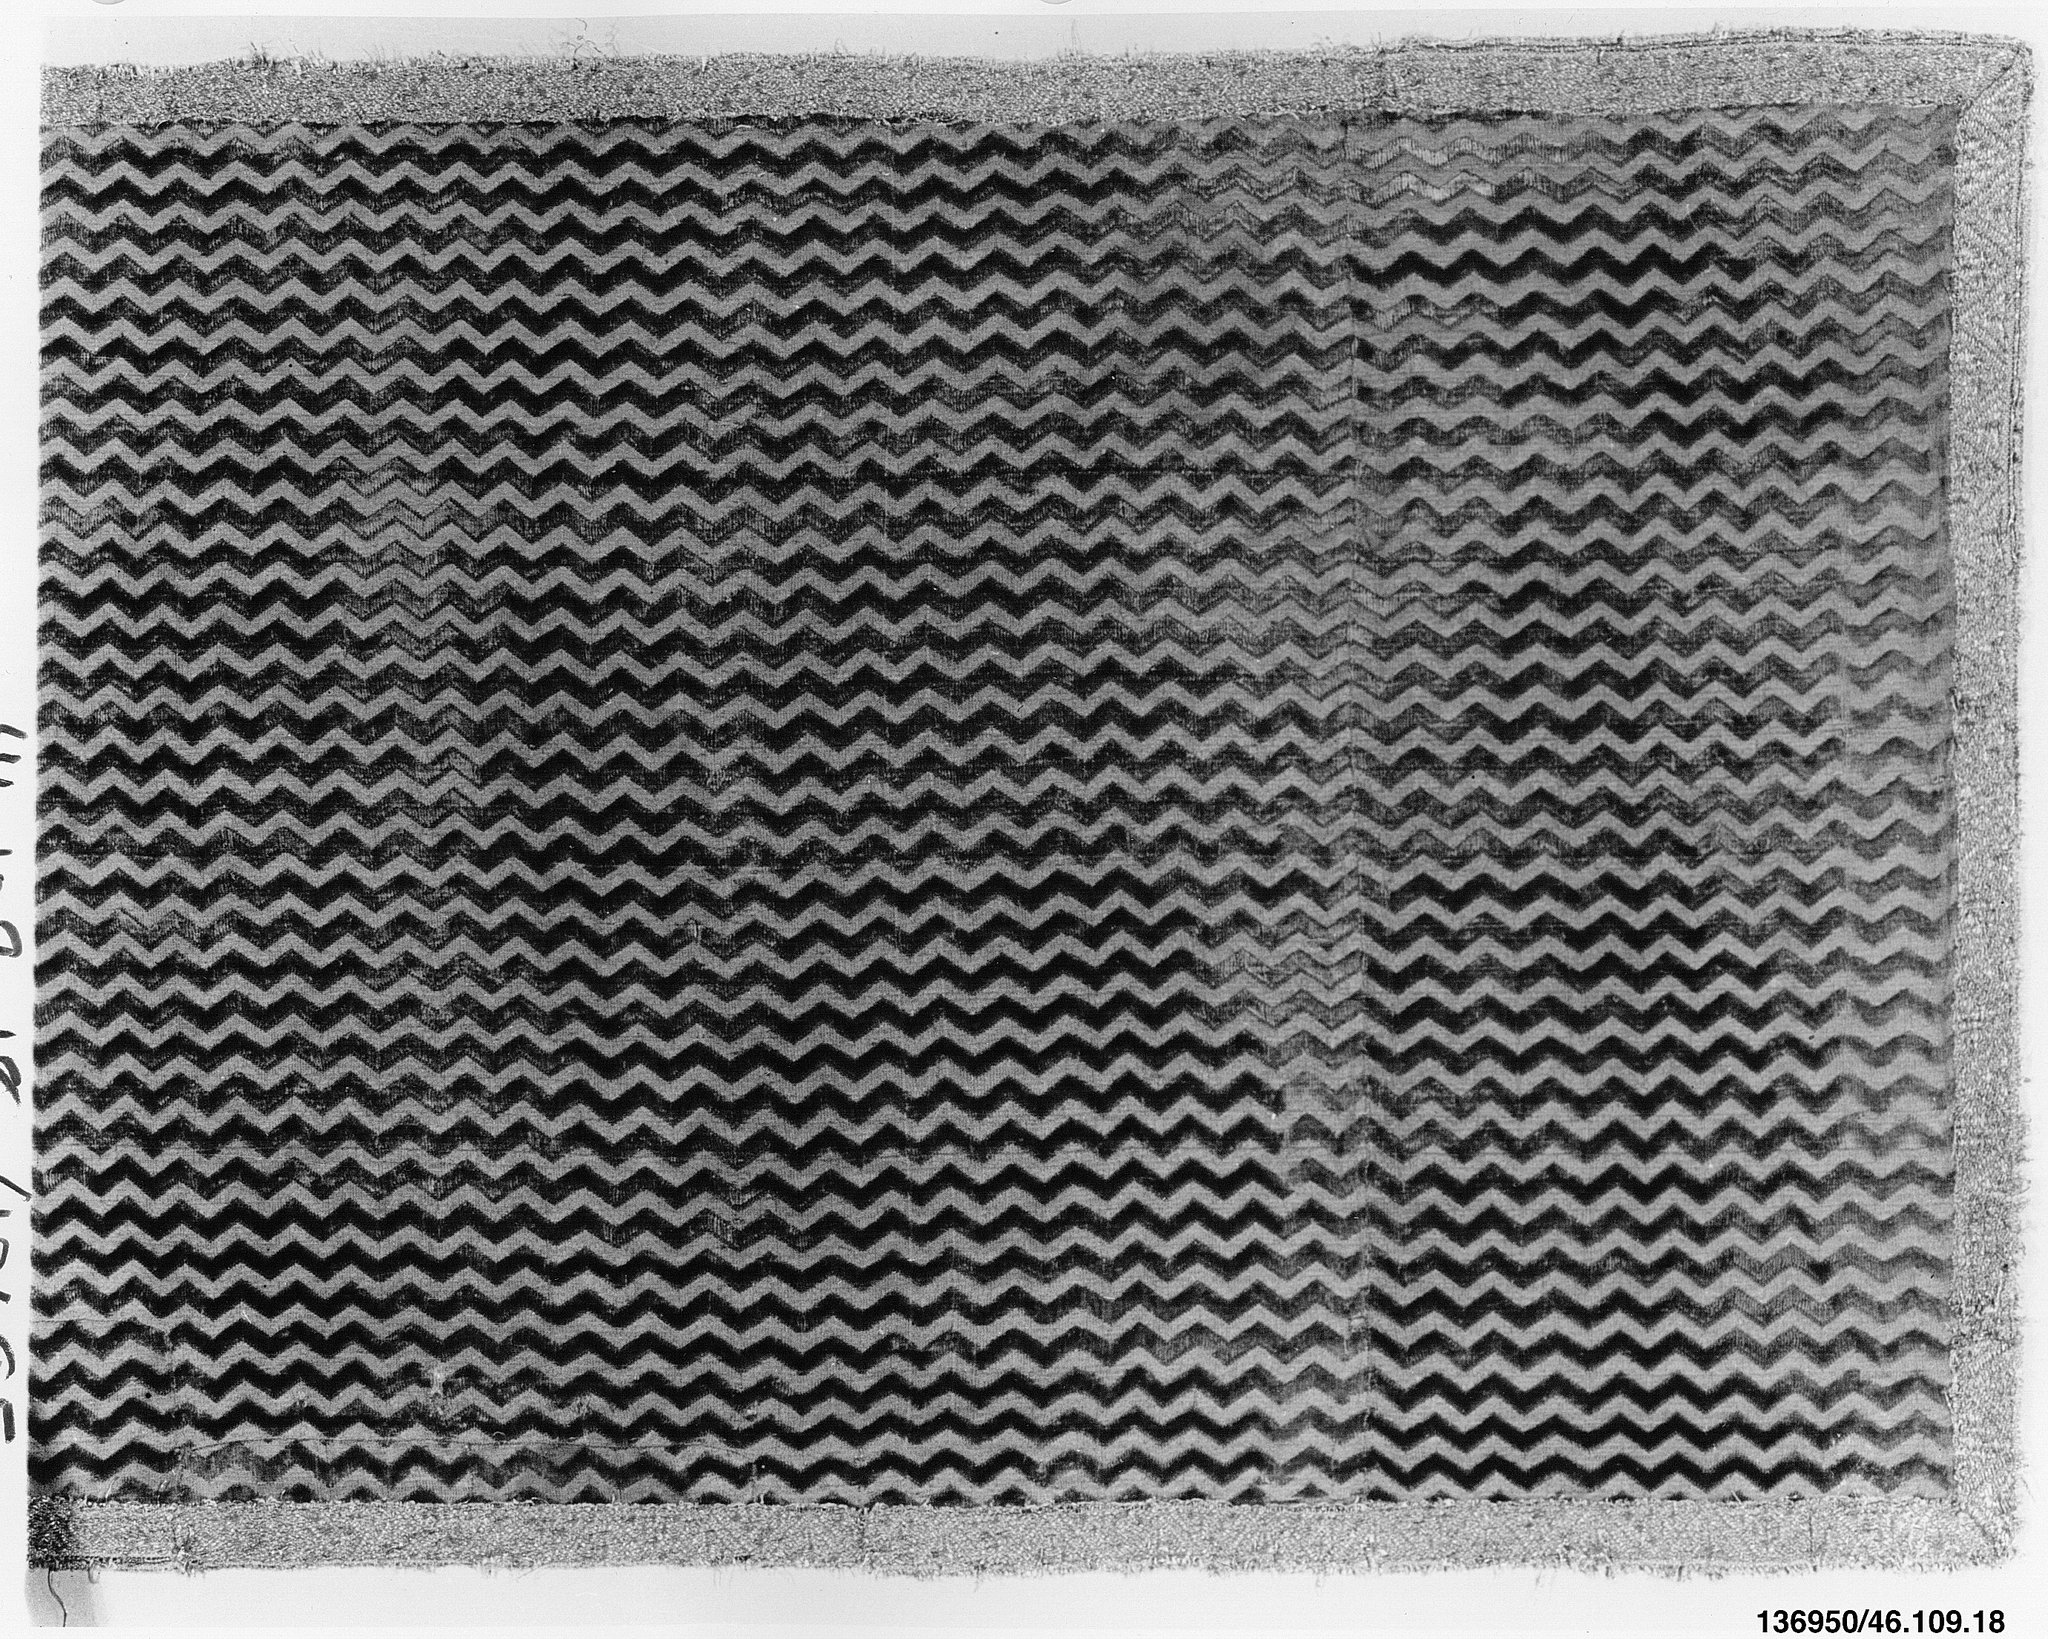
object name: piece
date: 1567-1633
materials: metal thread, silk